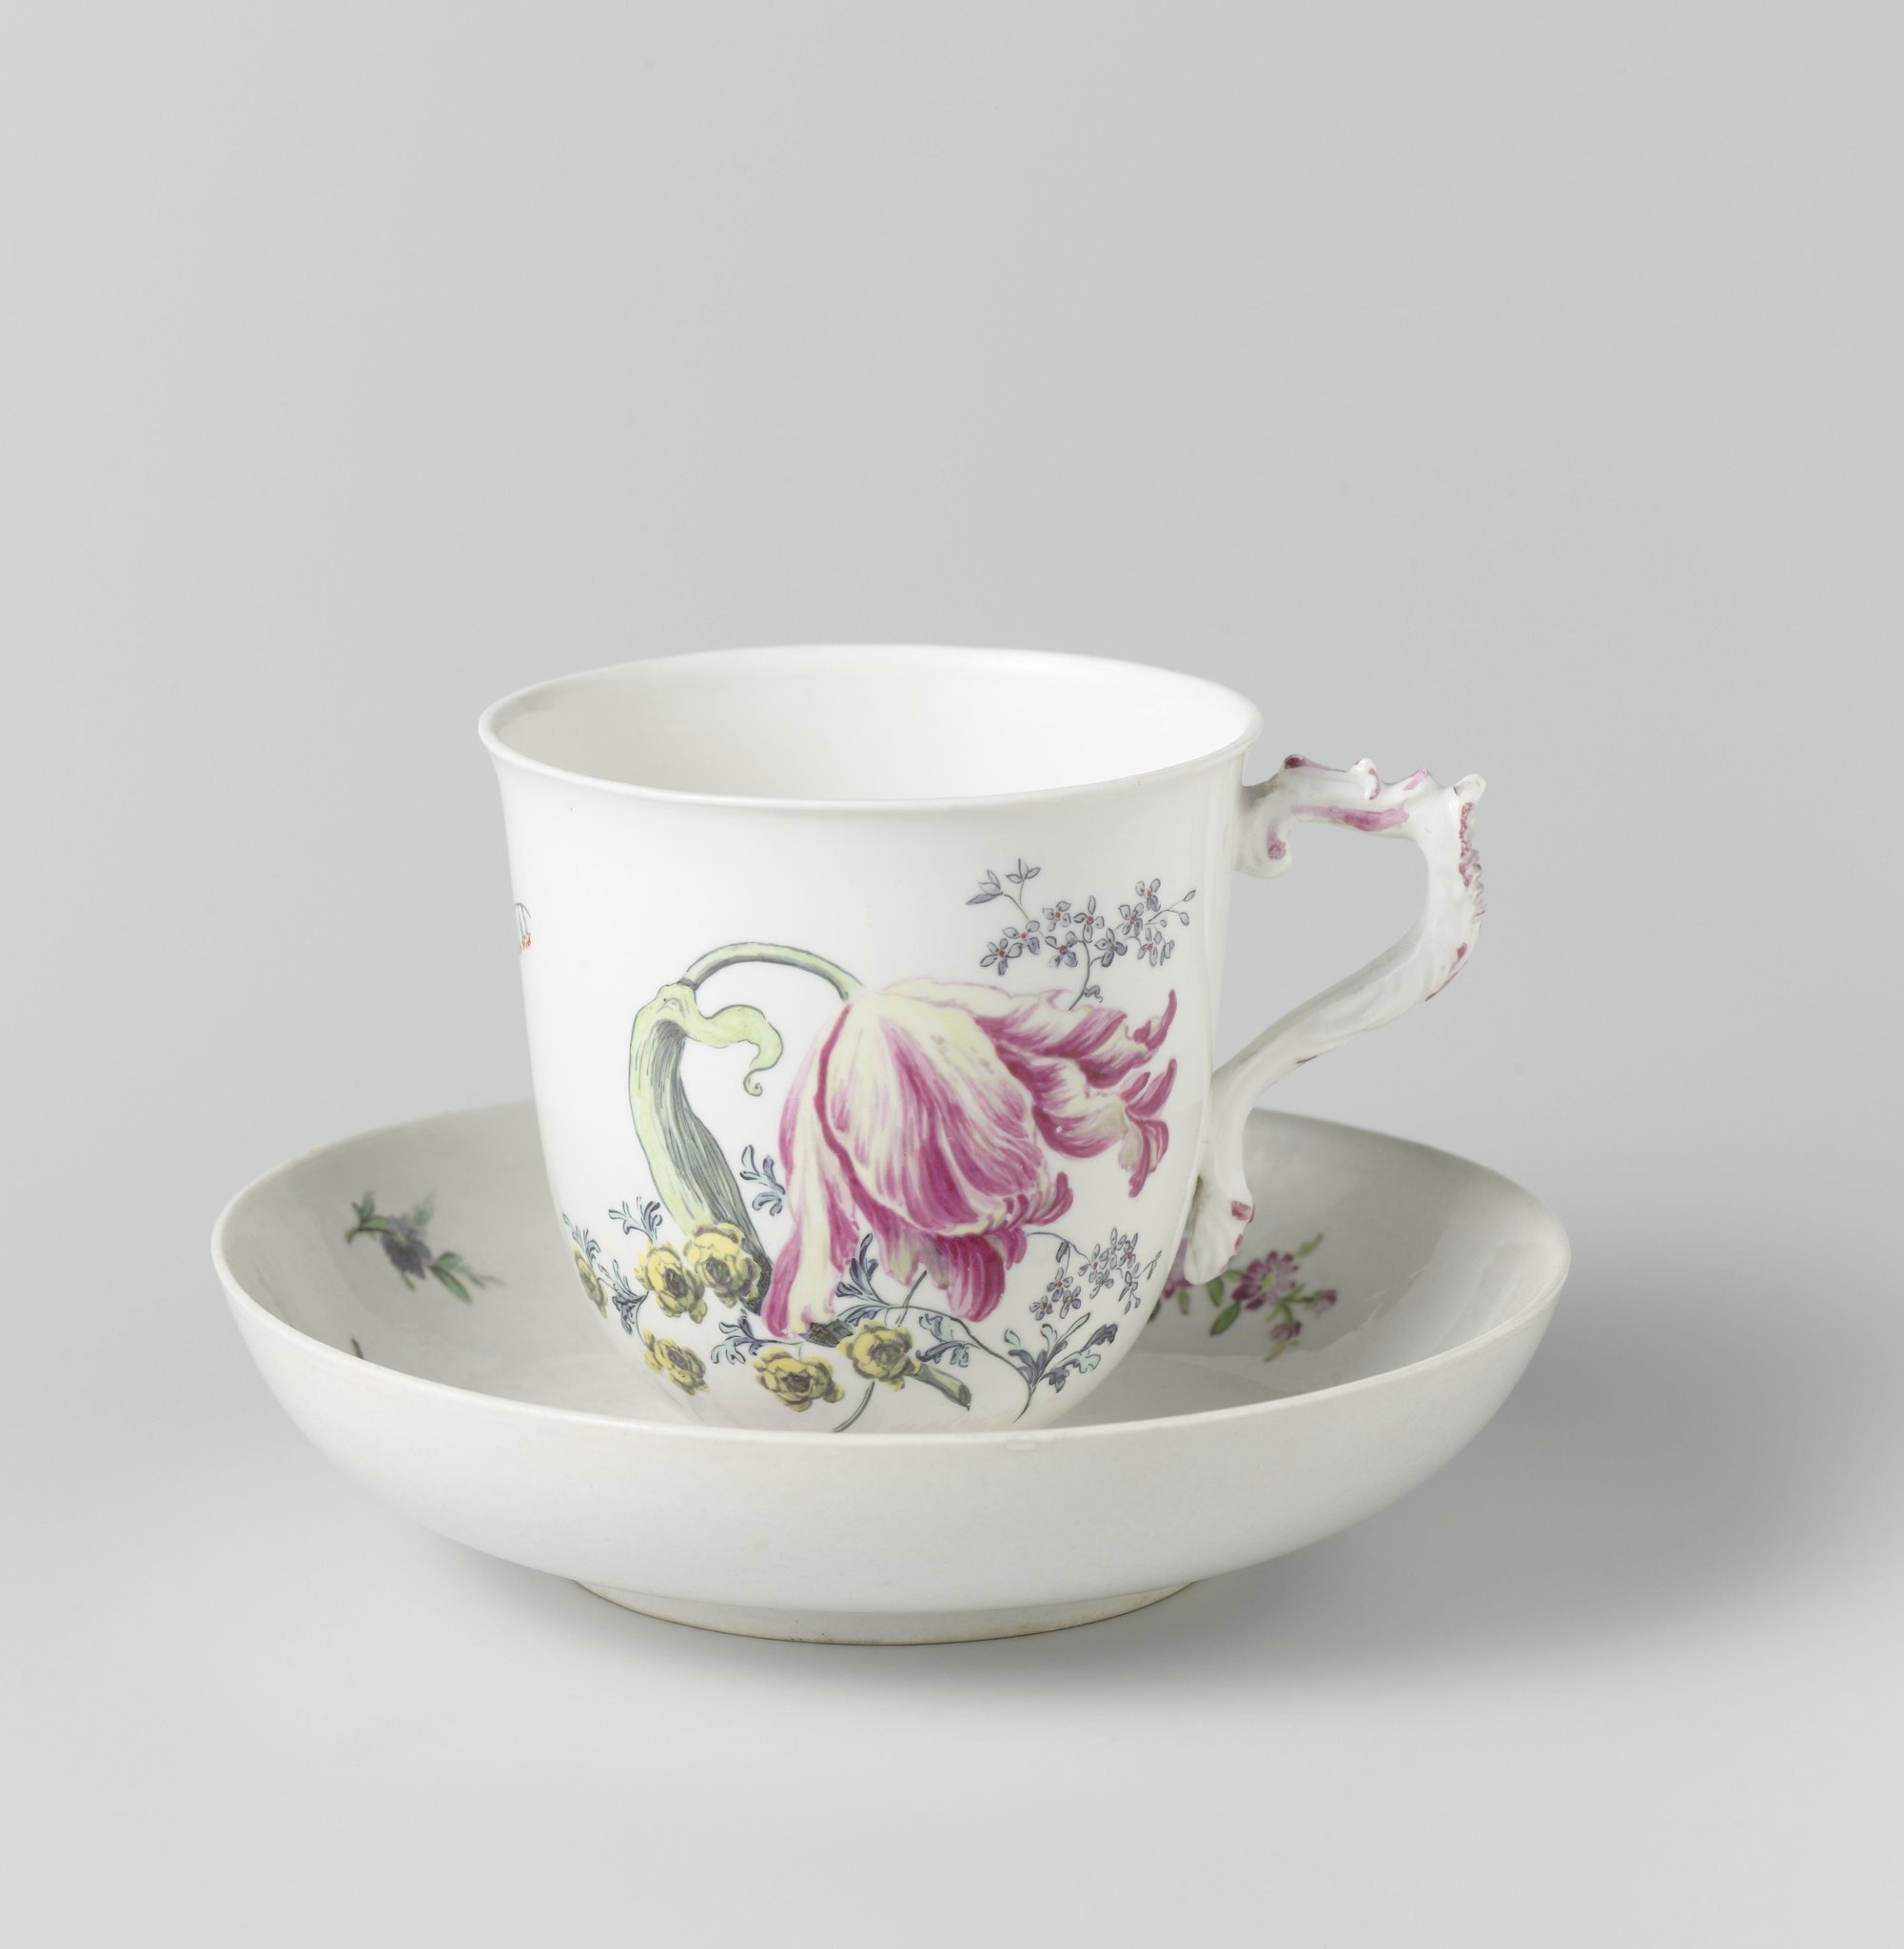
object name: kop en schotel, kop en schotel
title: Cup and saucer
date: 1759-1771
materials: porcelain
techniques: painted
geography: weesp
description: Weesper porseleinfabriek Weesp, c. 1759–1771 hard-paste porcelain